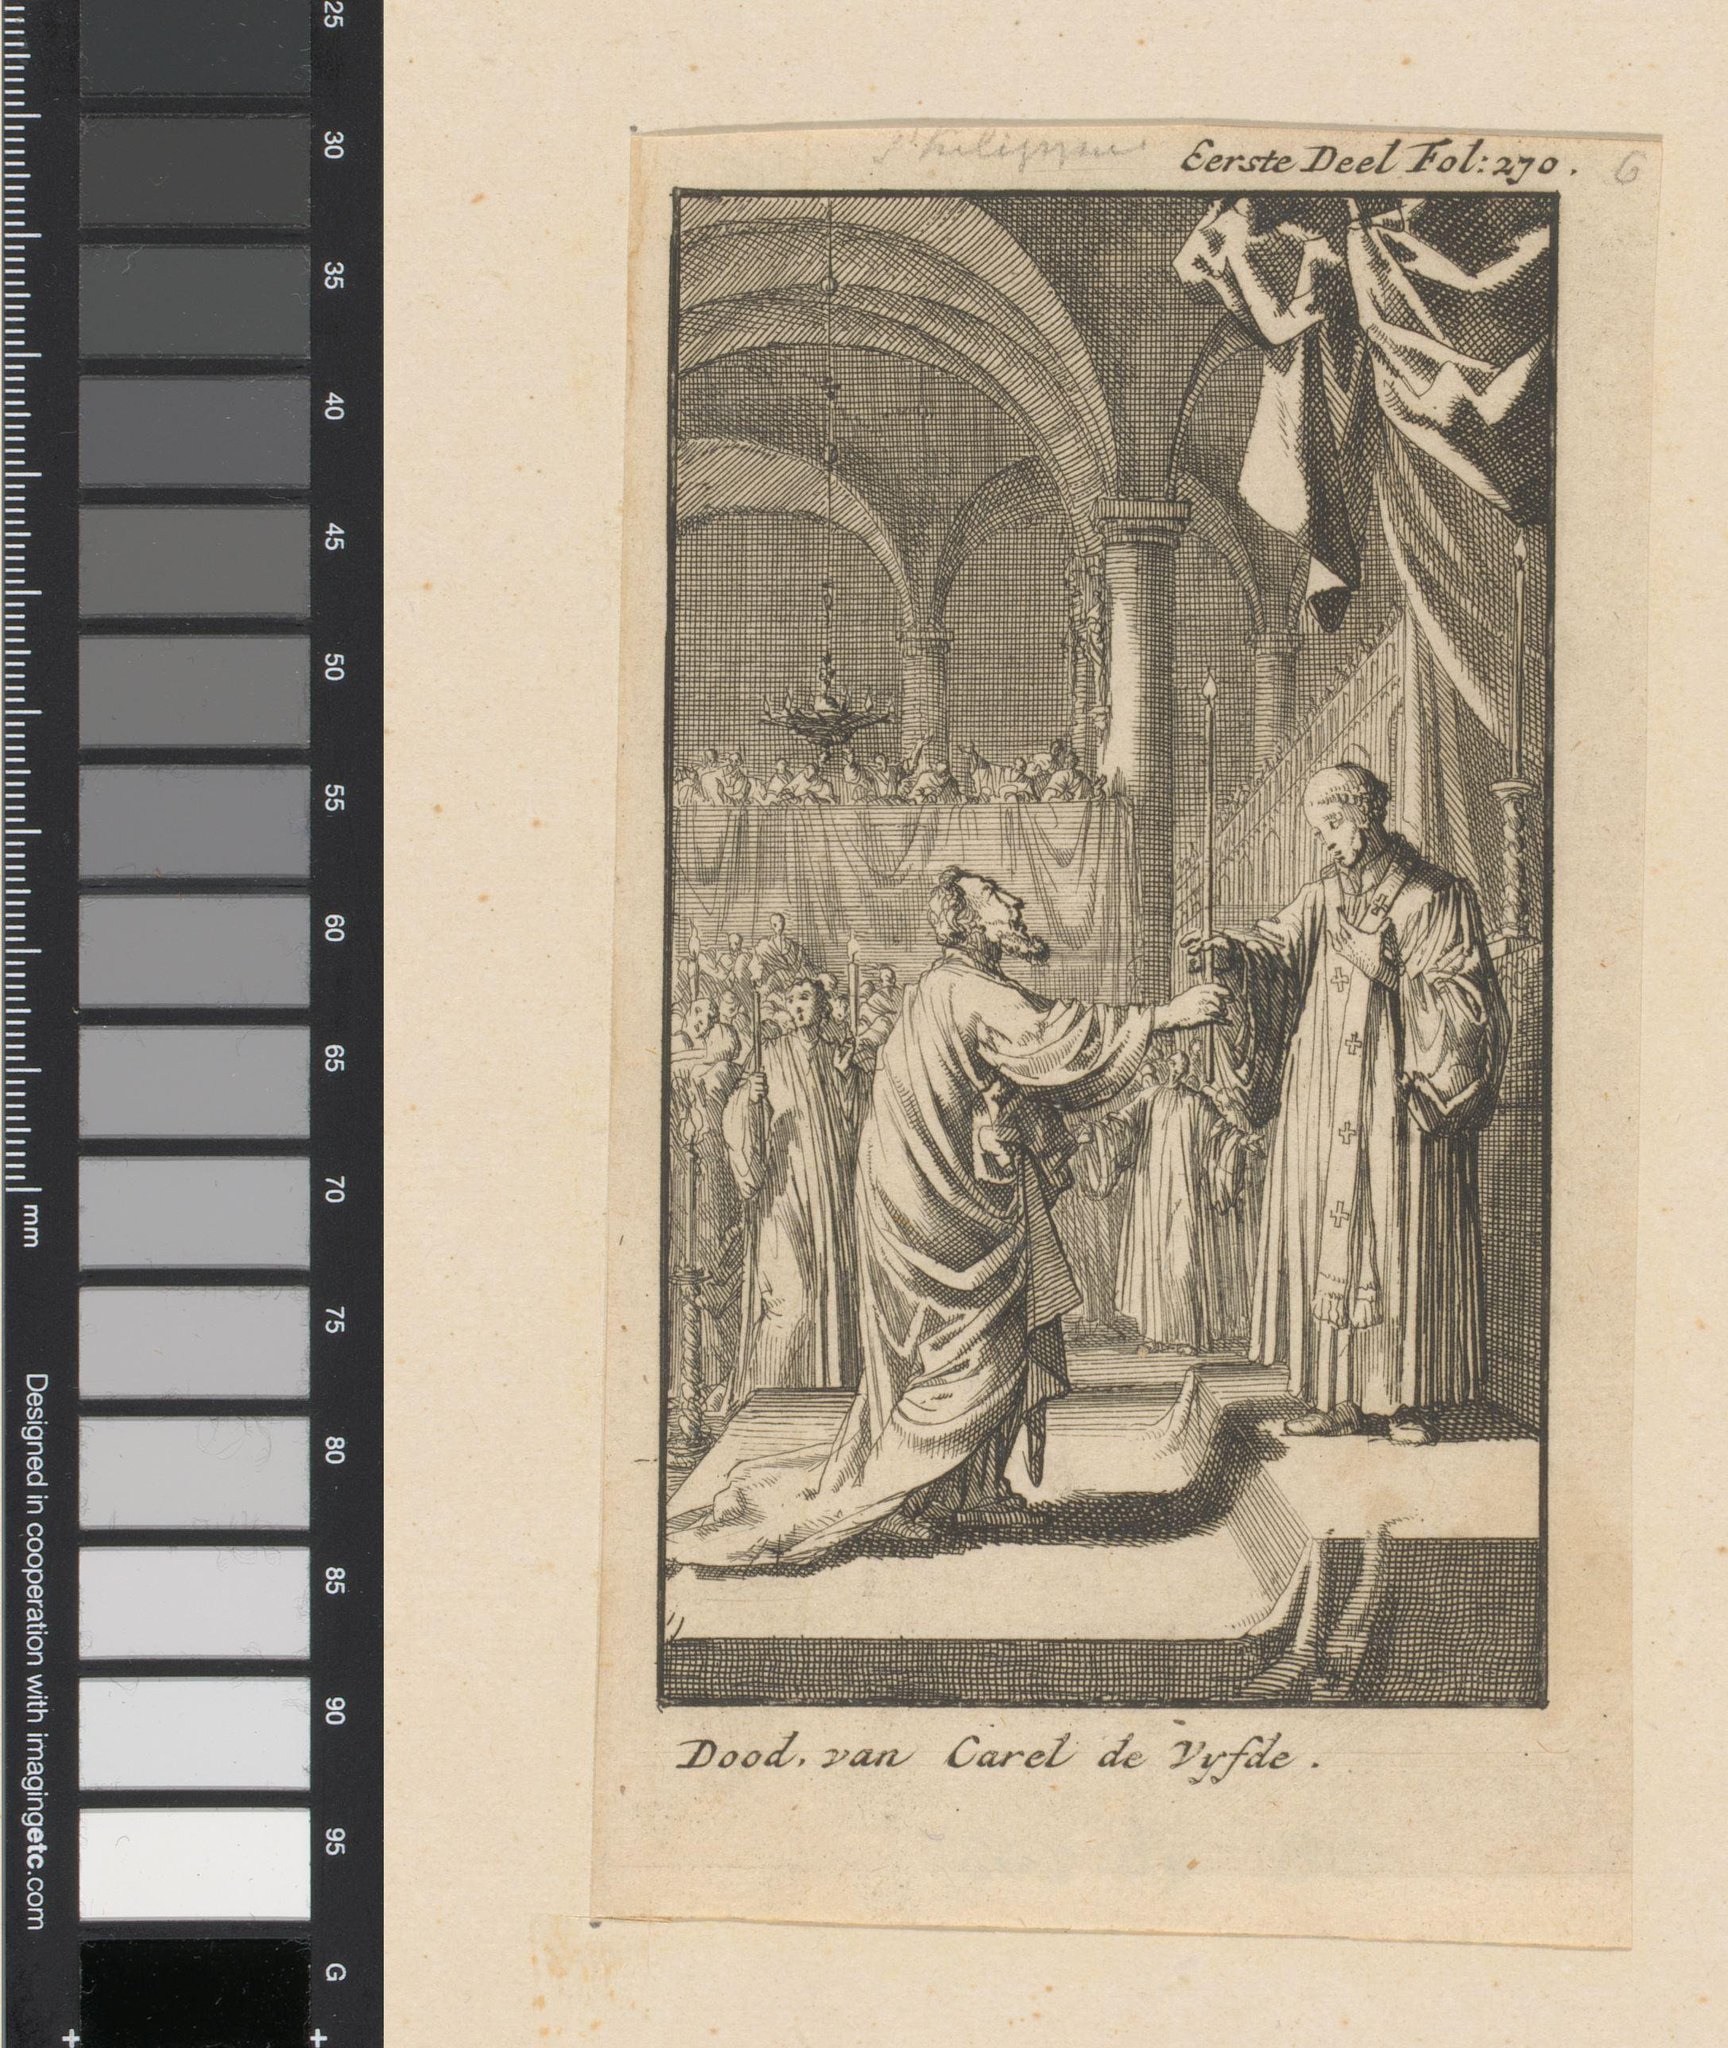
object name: print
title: Dood van Karel de Vijfde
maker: jan luyken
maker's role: draughtsman, print maker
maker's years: 1649-1712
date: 1659-1712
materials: paper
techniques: etching